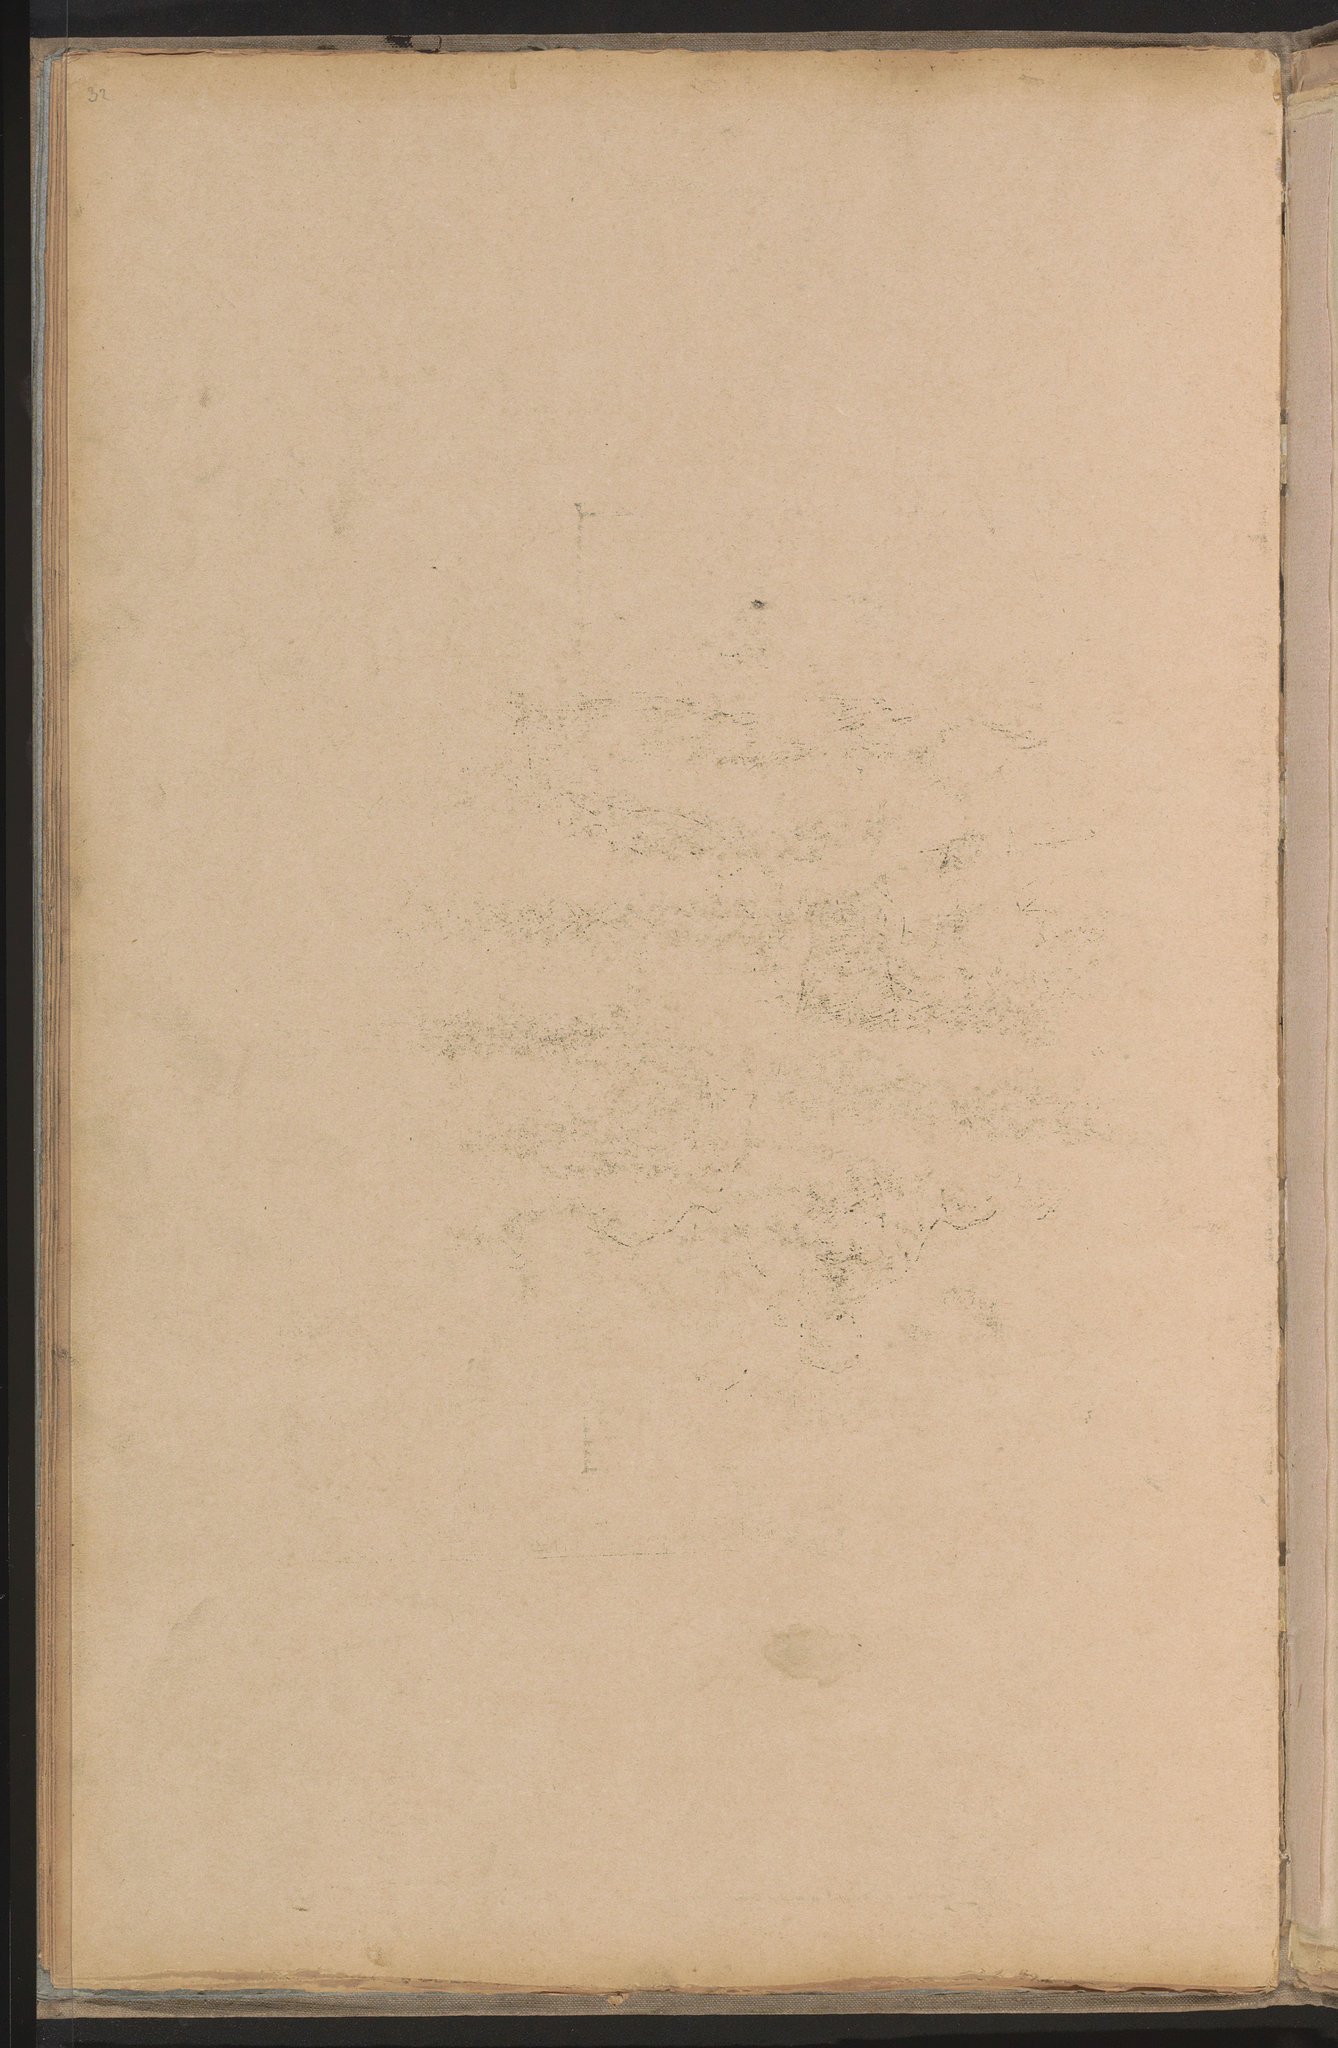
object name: sketchbook leaf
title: Abklatsch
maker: willem witsen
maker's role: draughtsman, painter, print maker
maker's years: 1860-1923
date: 1884-1887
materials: paper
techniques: printmaking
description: Pagina 32 uit een schetsboek met 38 bladen.